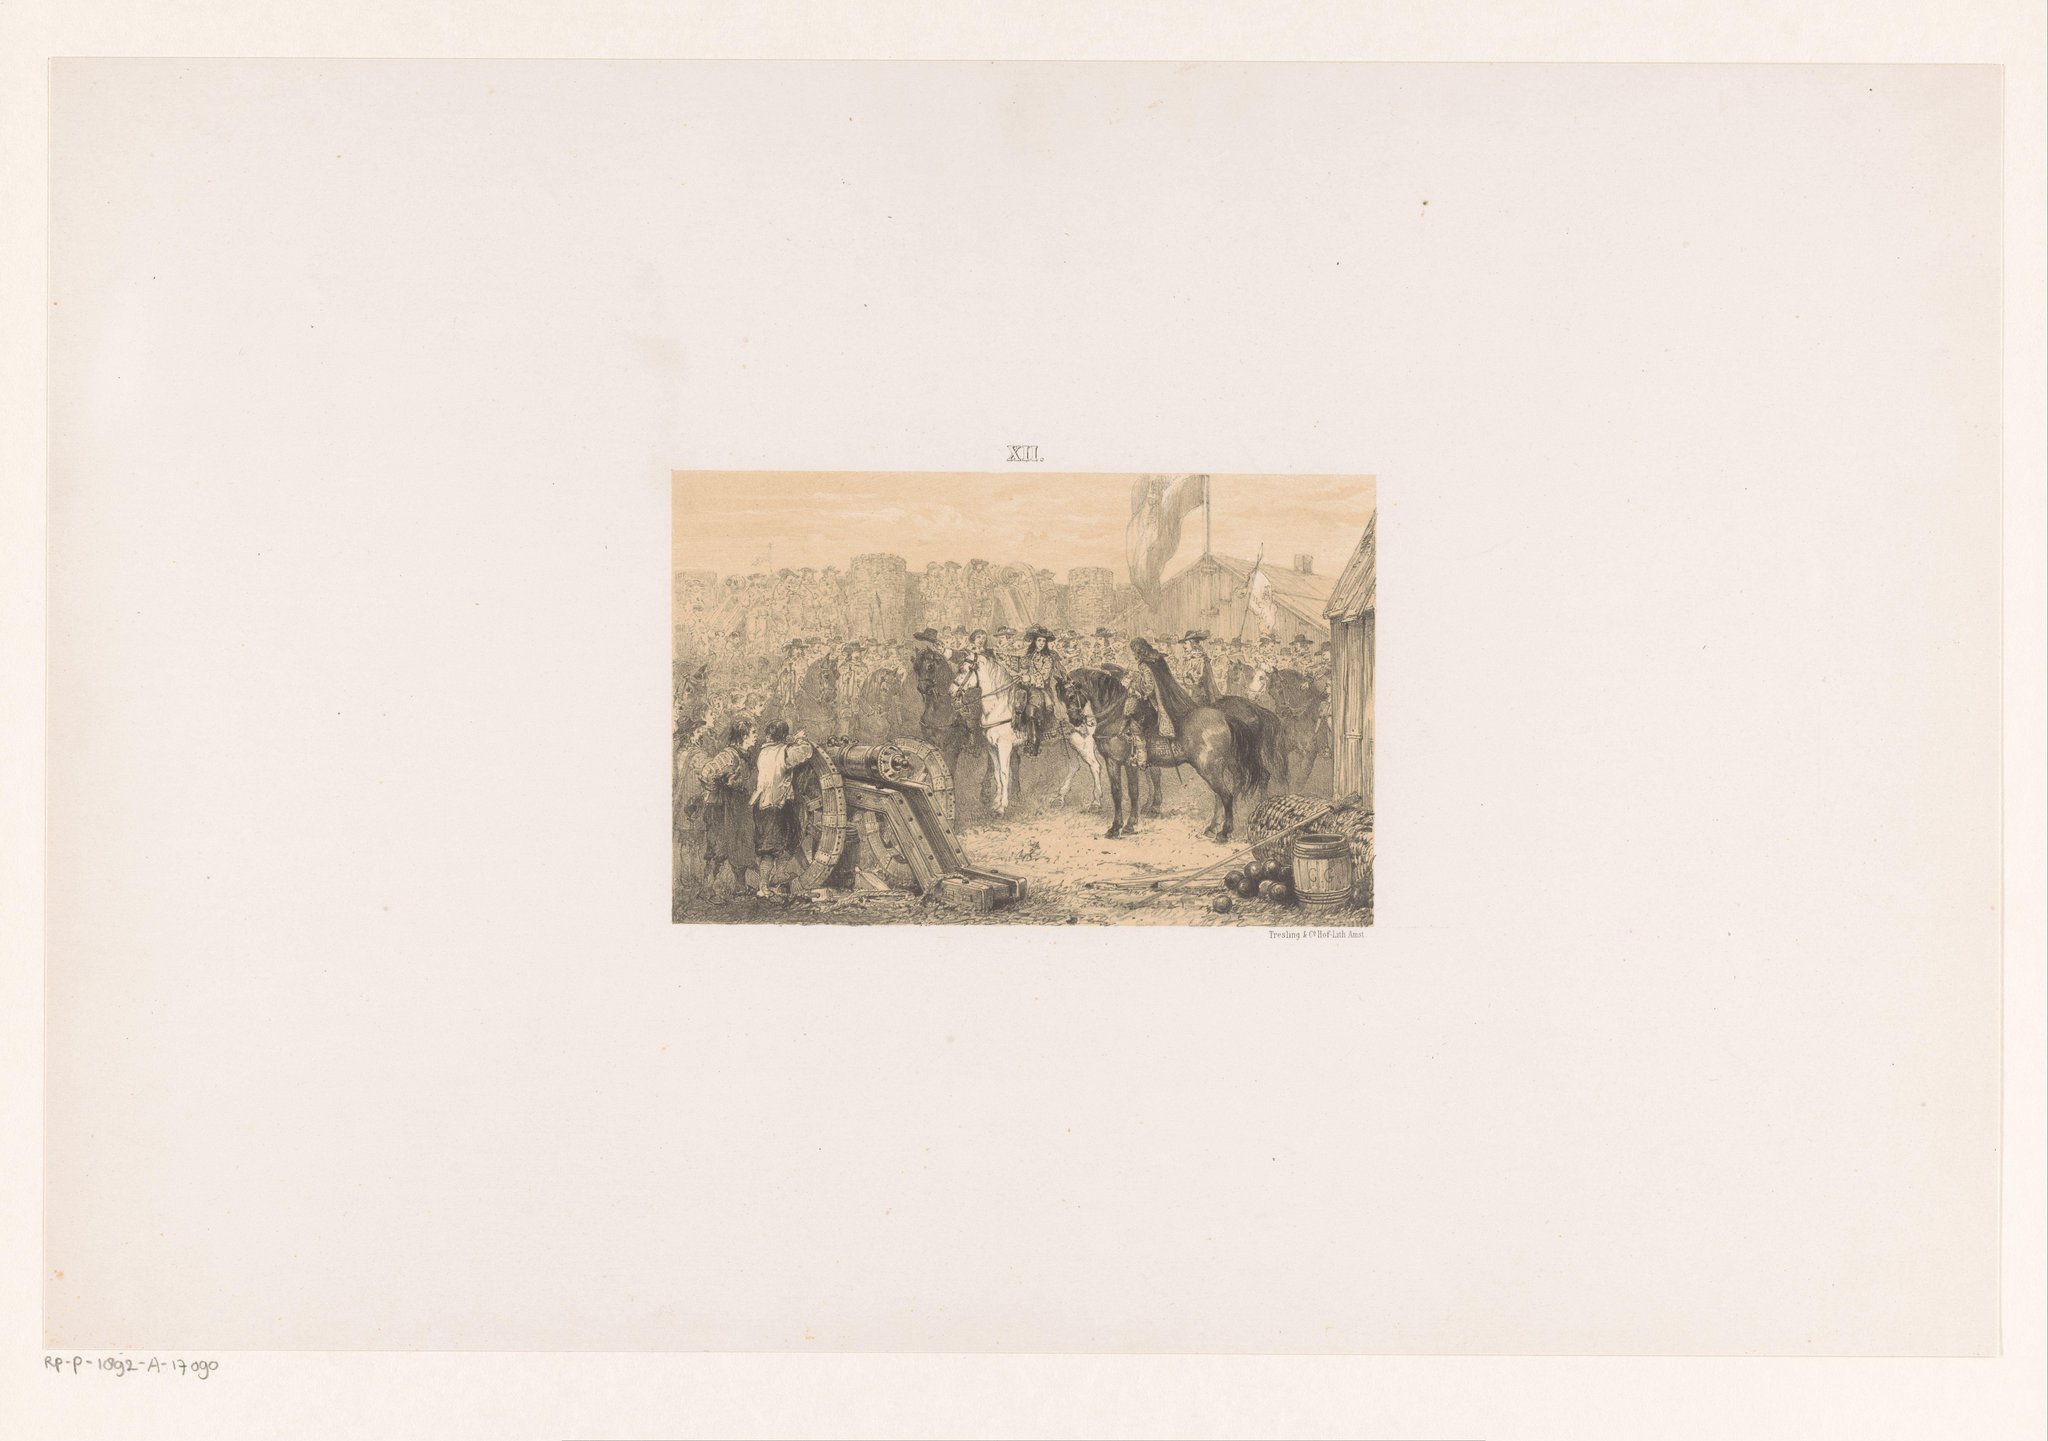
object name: print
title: Prins Willem II inspecteert de verdediging van Amsterdam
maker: johan conrad greive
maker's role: draughtsman, painter, print maker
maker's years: 1837-1891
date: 1876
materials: paper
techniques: tone lithography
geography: amsterdam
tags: land forces (+ cavalry, horsemen), towers ~ fortified city, horse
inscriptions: collector's mark: Lugt 2228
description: Het leger is te paard. In de voorgrond staat een kanon. De aanvoerders hebben zich in het midden verzameld.